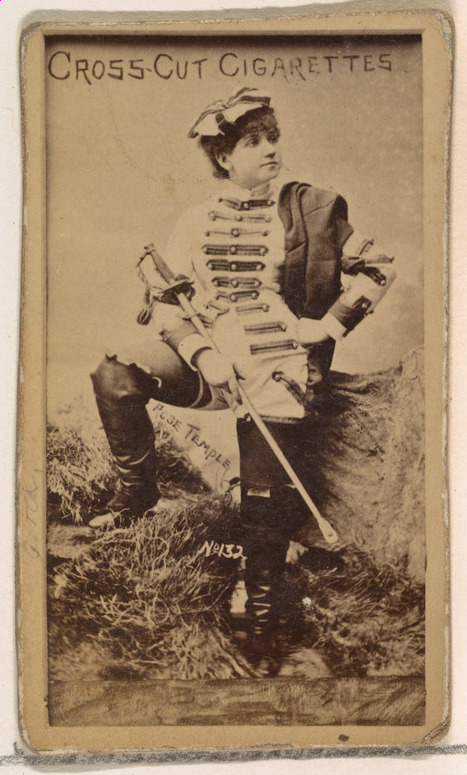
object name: print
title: Card Number 132, Rose Temple, from the Actors and Actresses series (N145-1) issued by Duke Sons & Co. to promote Cross Cut Cigarettes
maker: w. duke, sons & co.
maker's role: publisher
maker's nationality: american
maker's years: 1870-1920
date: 1880-1889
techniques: albumen silver print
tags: portraits,women,actresses